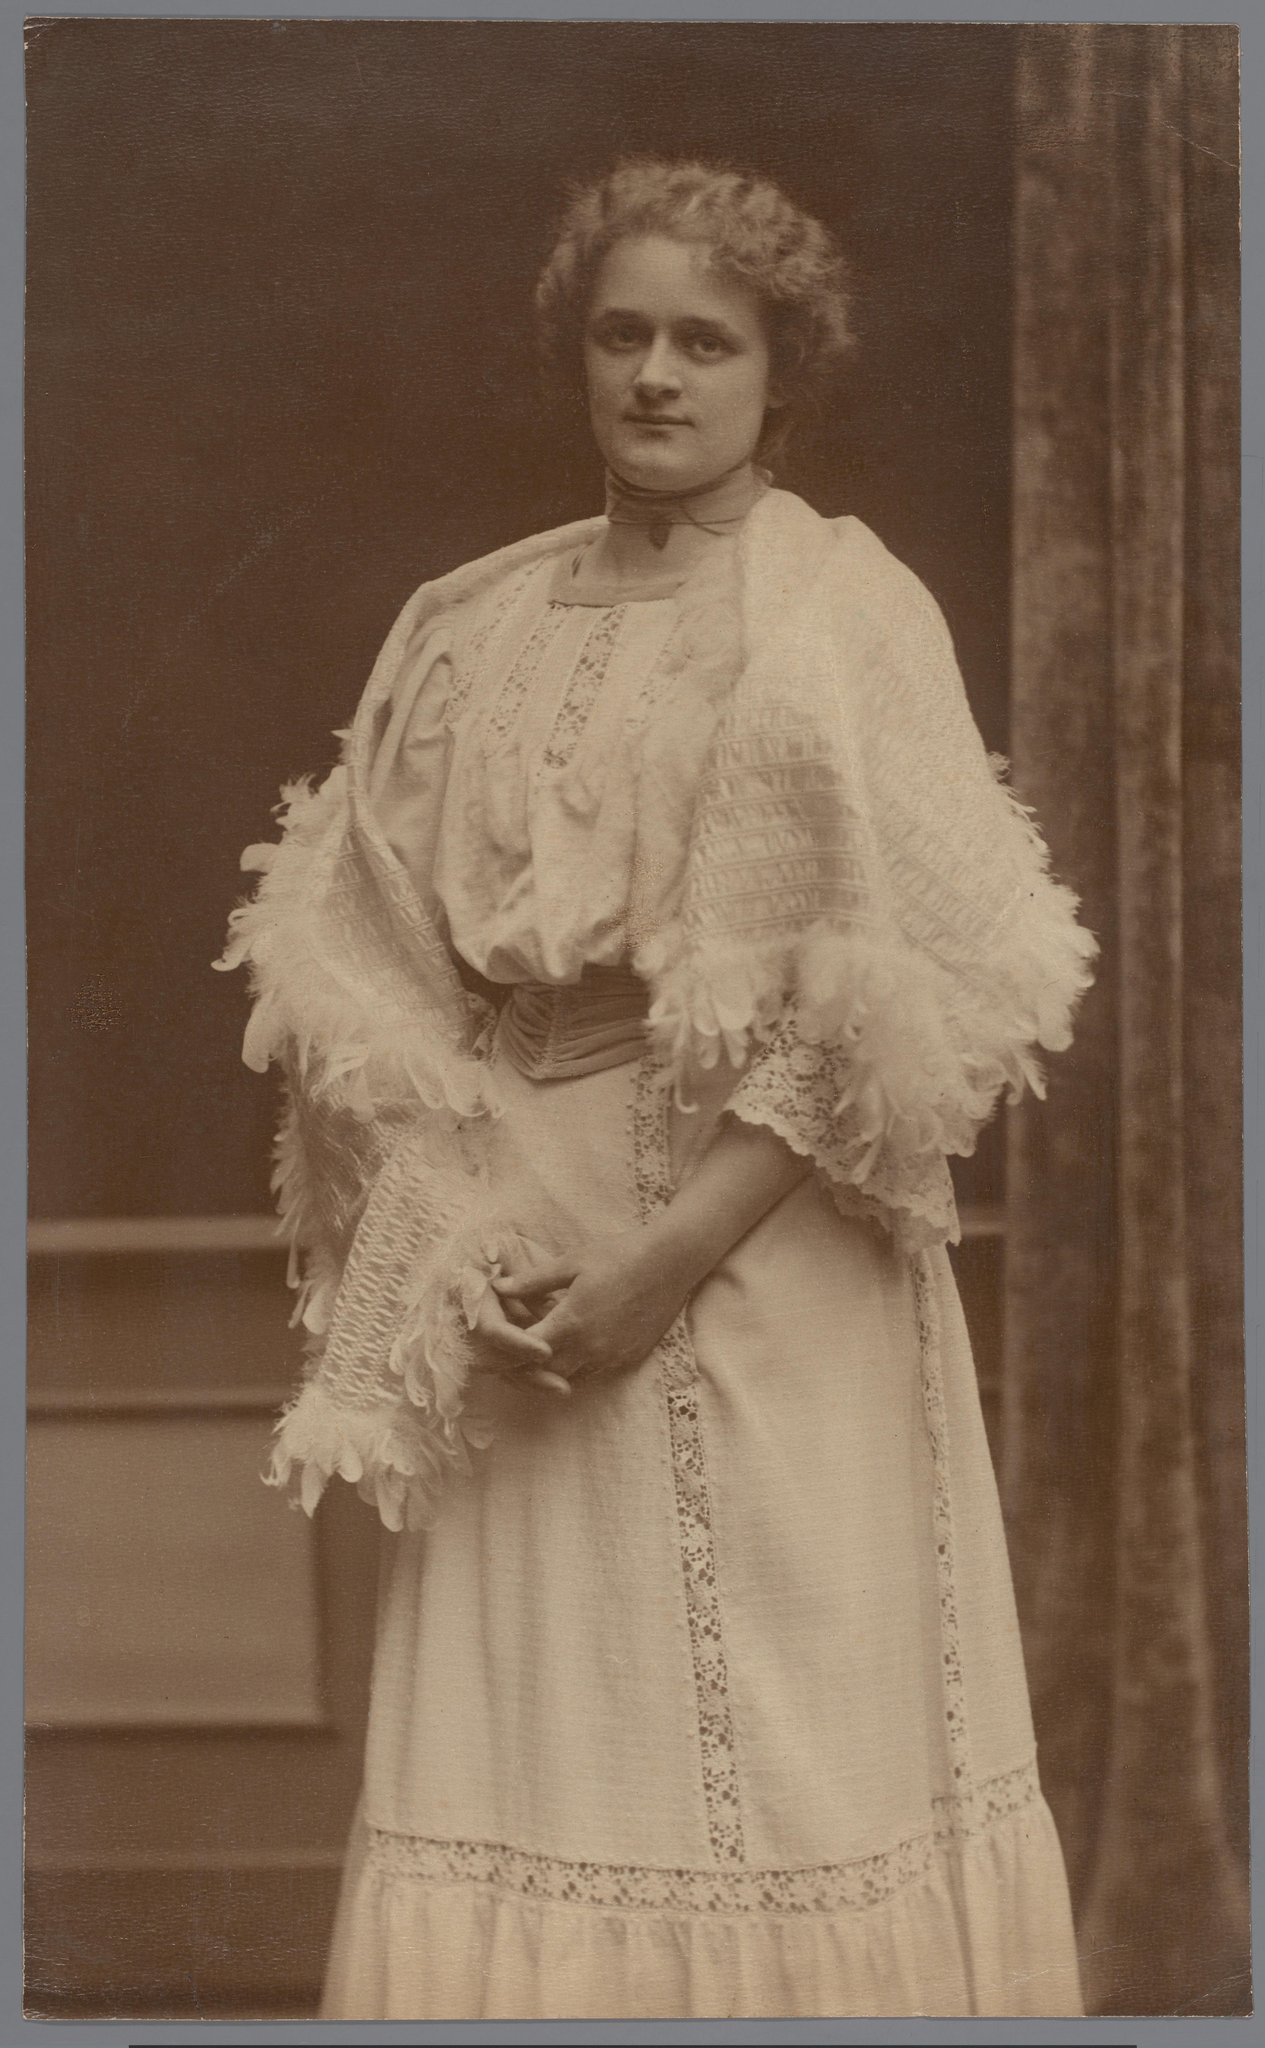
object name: photograph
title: Portret van een onbekende vrouw met stola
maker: Anonymous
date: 1890-1910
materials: paper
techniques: carbon print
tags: historical persons - bb - woman